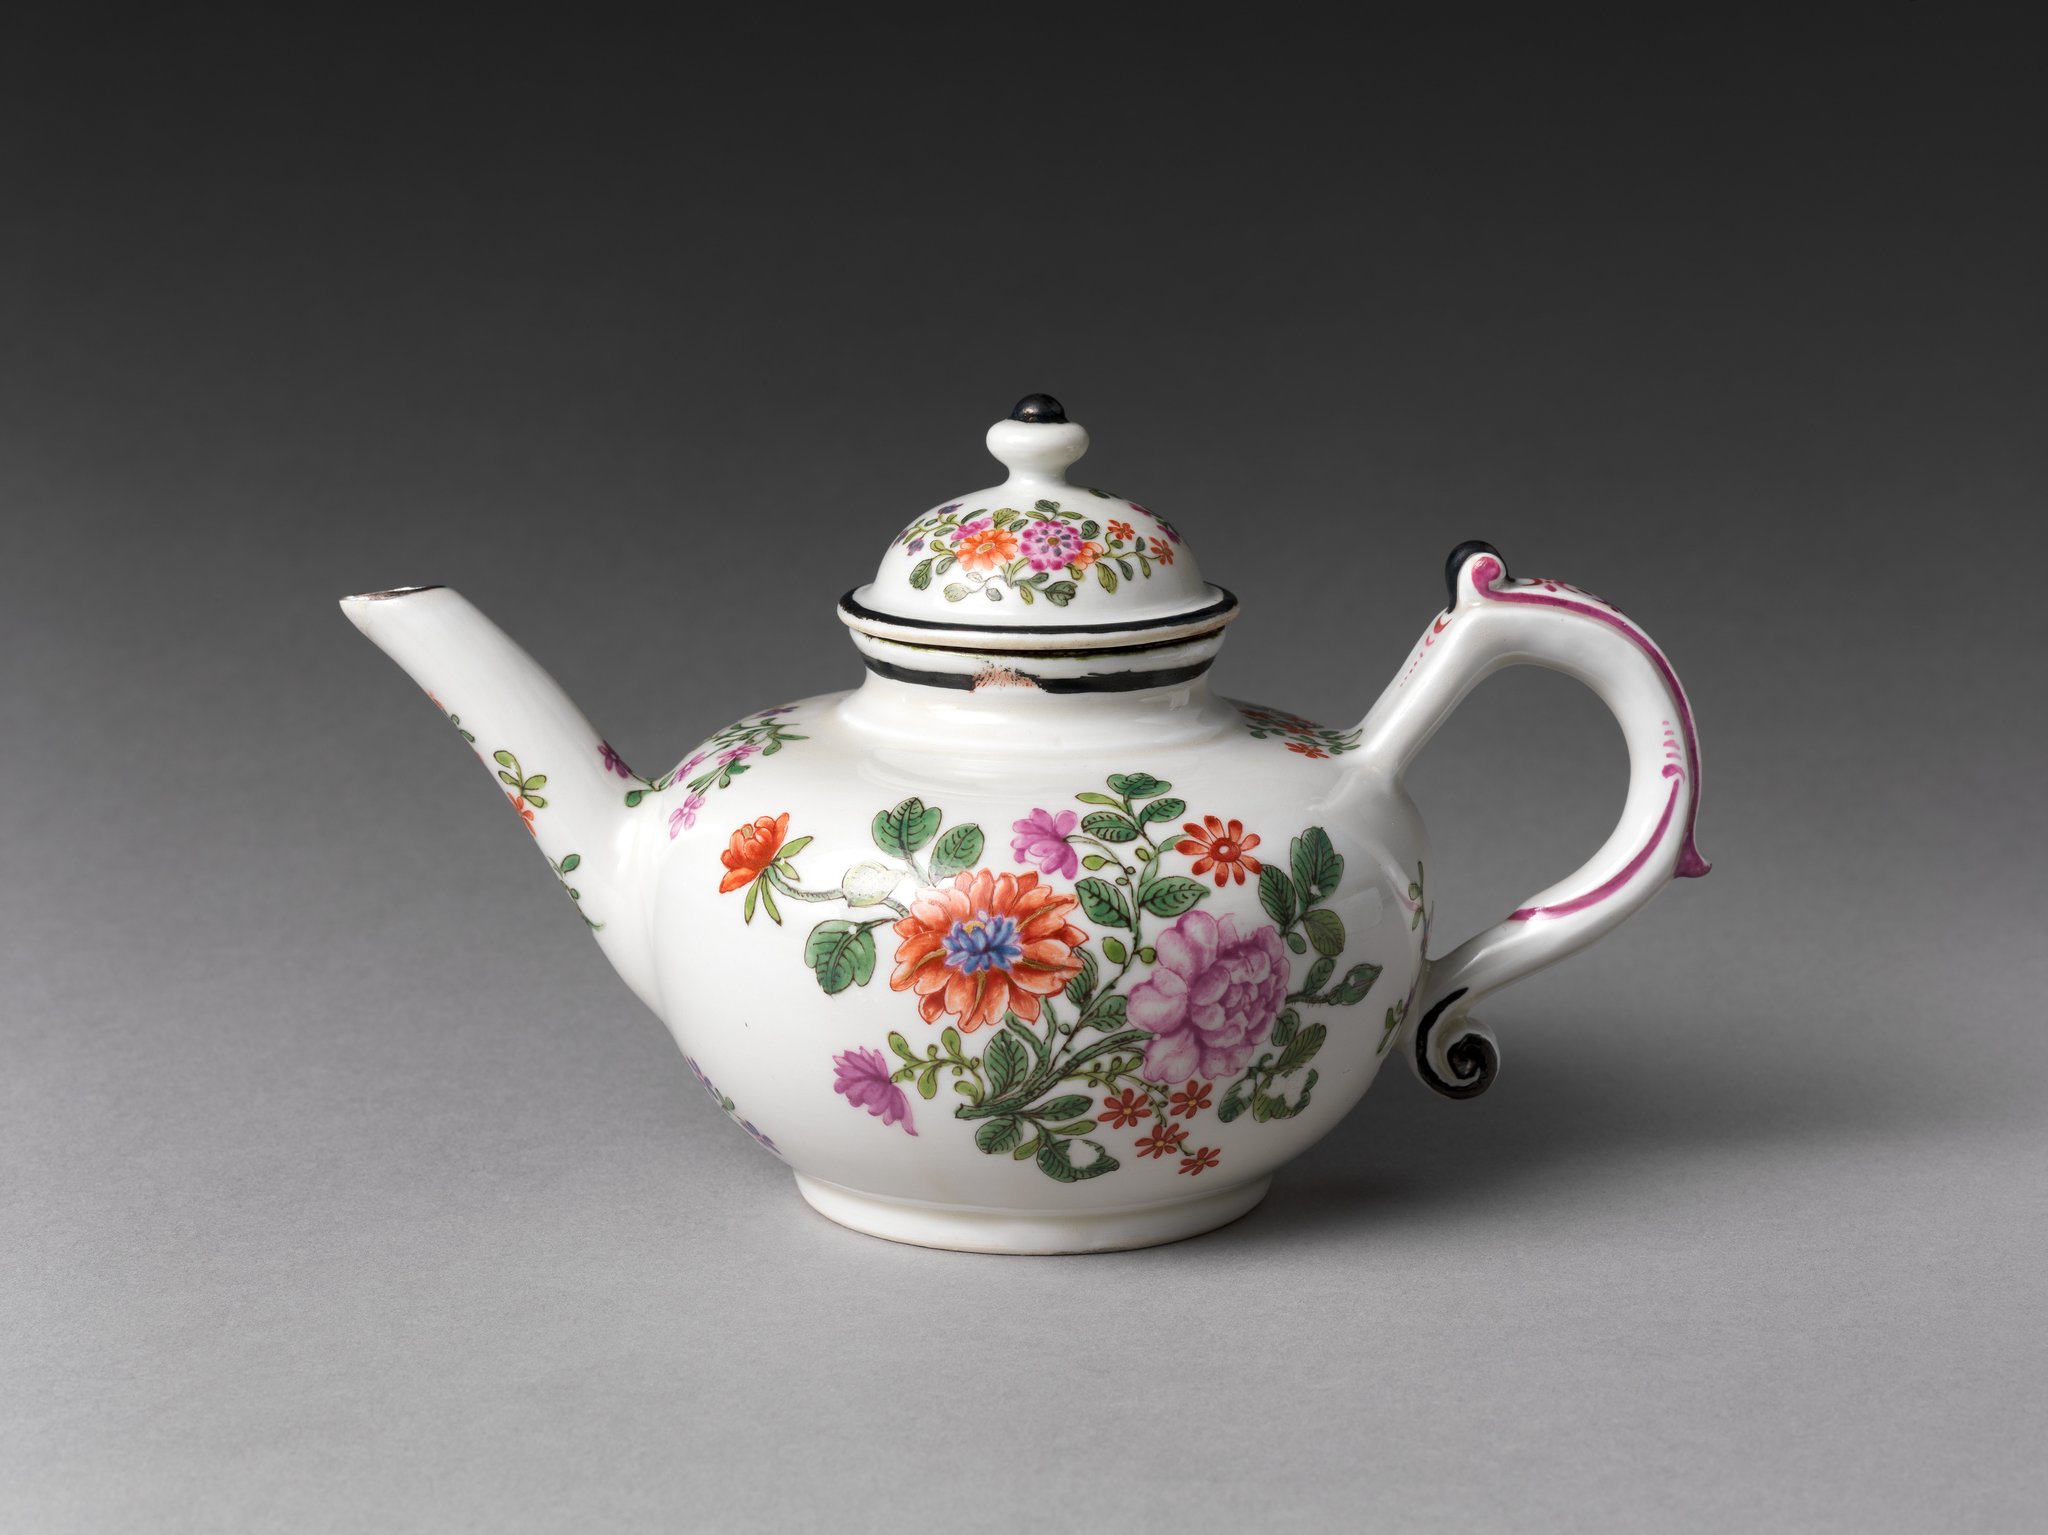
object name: teapot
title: Teapot with peonies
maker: vienna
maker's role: manufactory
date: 1735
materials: enamel, glaze, hard paste porcelain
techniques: painting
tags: peonies